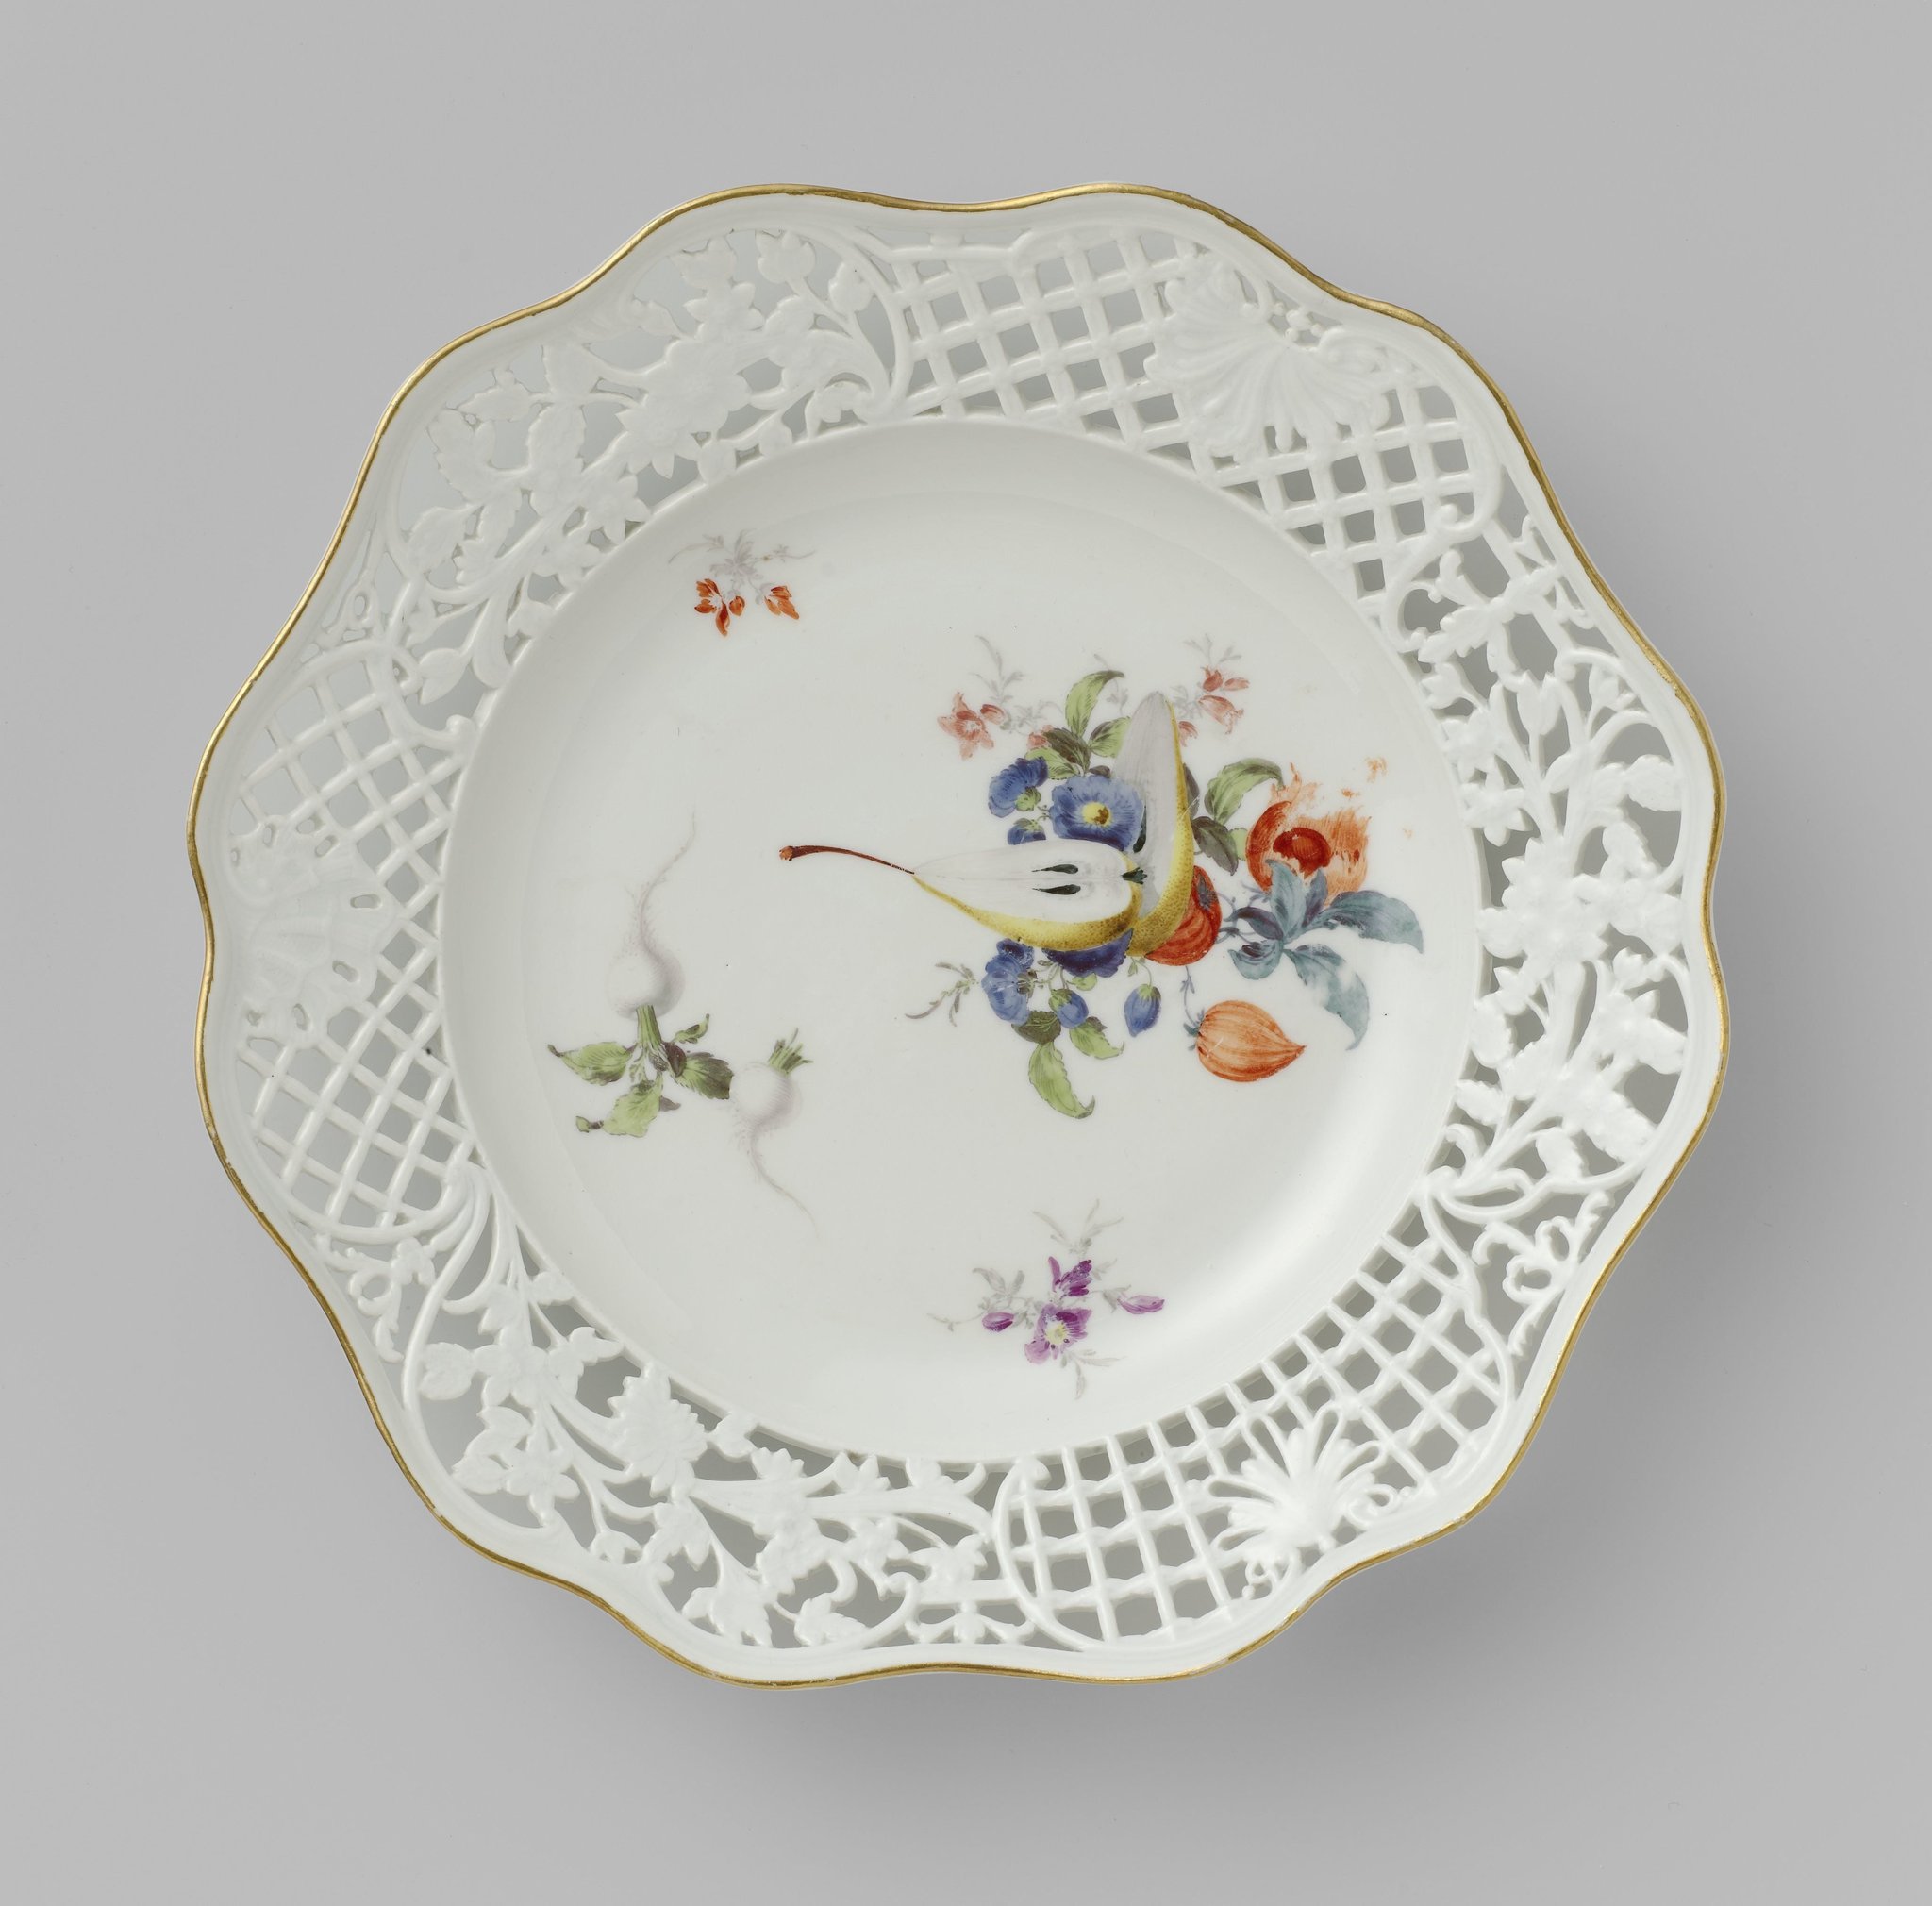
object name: dessert plate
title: Dessertbord, veelkleurig beschilderd met bloemen en vruchten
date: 1750-1760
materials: porcelain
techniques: painted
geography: meissen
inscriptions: factory mark, mold mark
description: Rond dessertbord van beschilderd porselein. De geschulpte rand is opengewerkt met afwisselend een netwerk met een palmet en takken met bladeren en bloemen. De spiegel is beschilderd met bloemen en vruchten. Het bord is gemerkt.